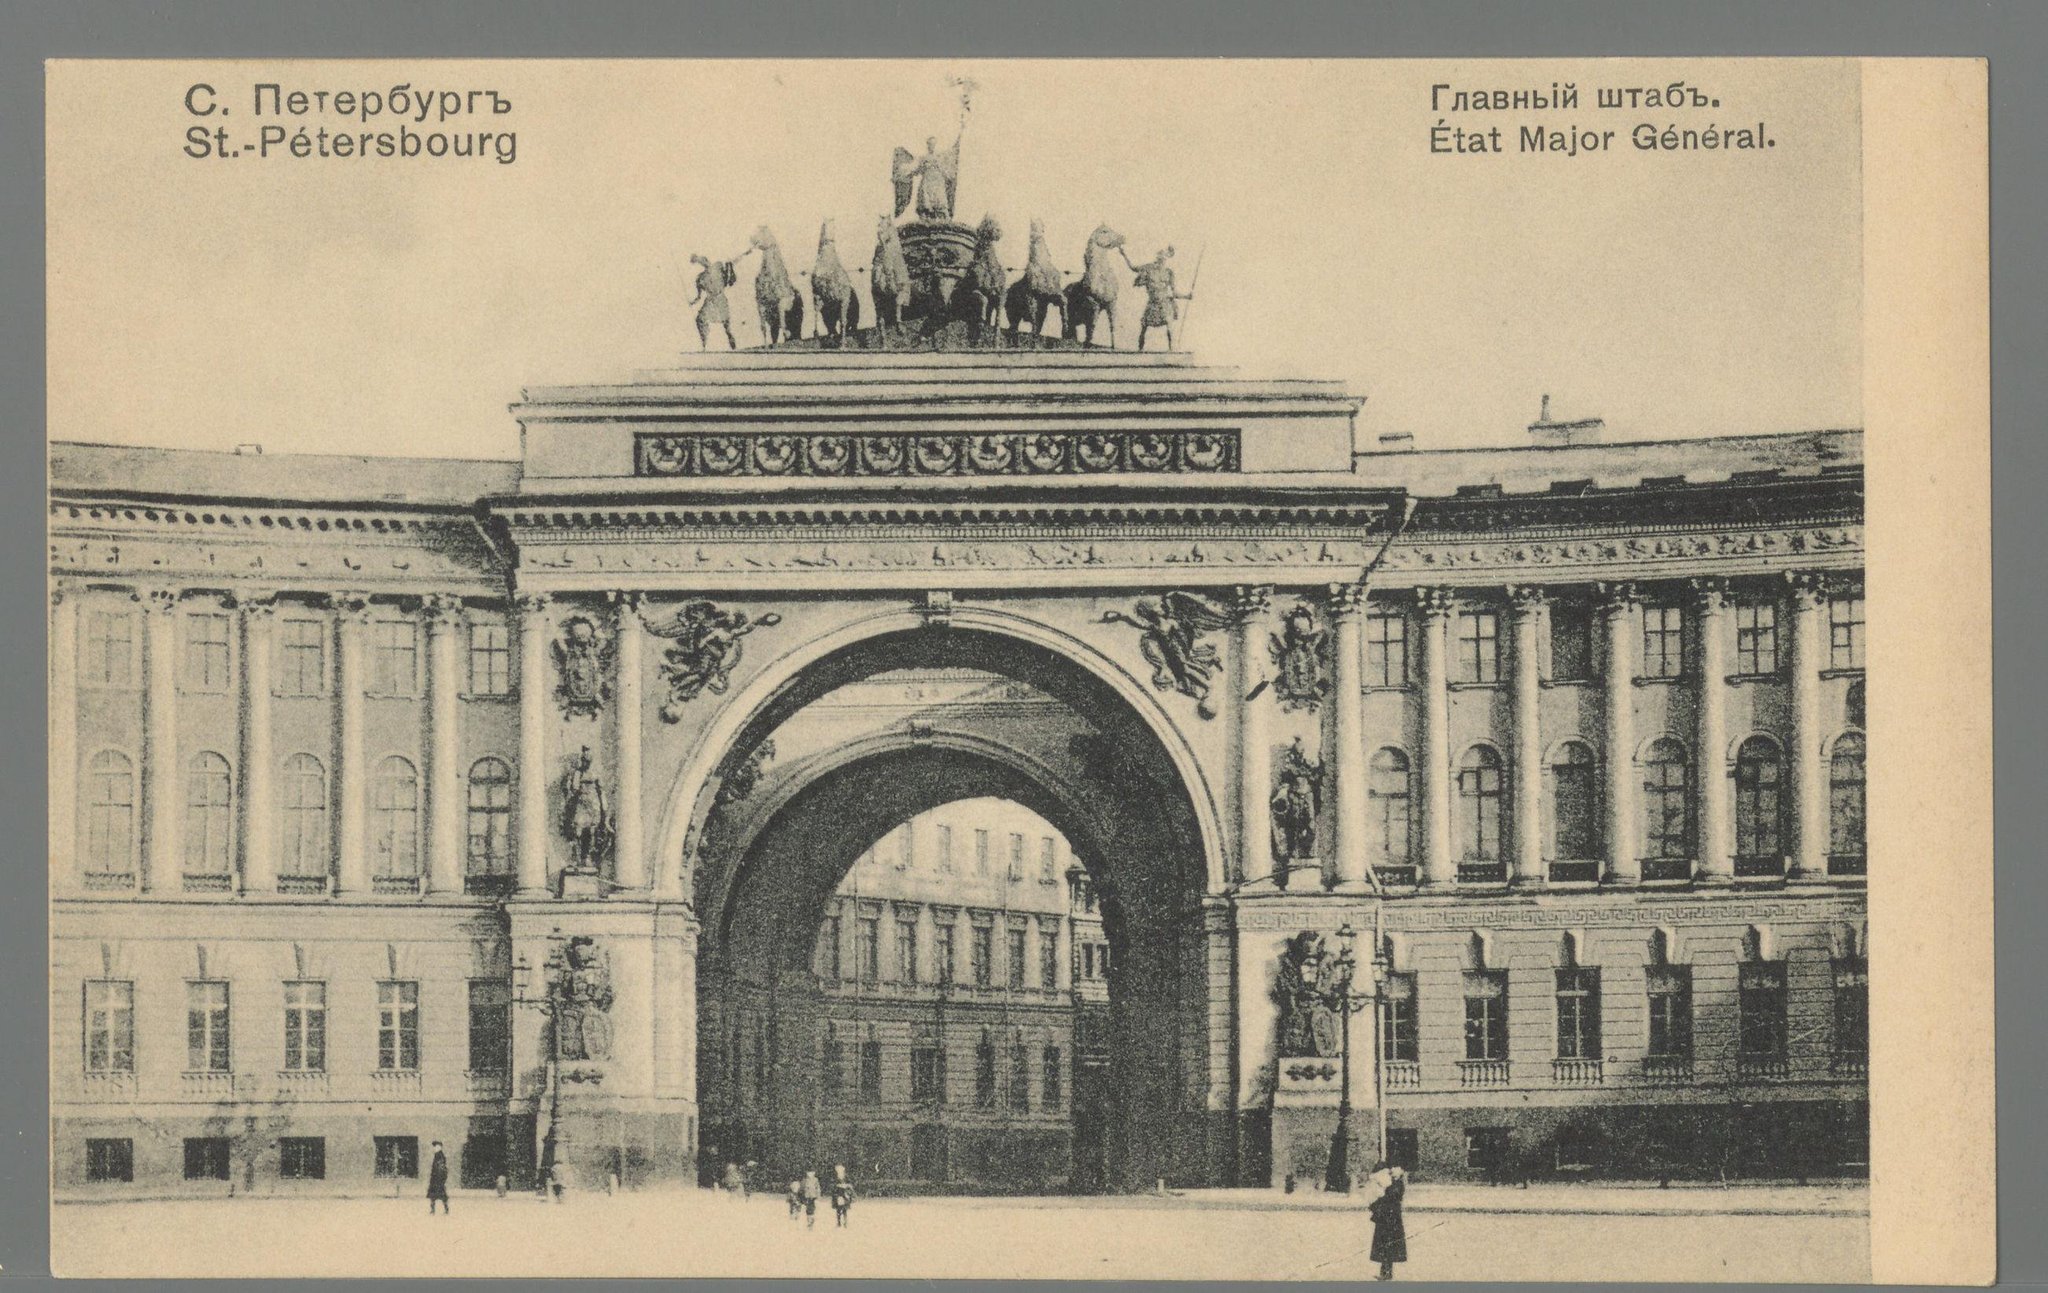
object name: photomechanical print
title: St.-Pétersbourg. État Major Général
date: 1904-1930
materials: cardboard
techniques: photograph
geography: sint-petersburg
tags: edifice, e.g.: public building, department store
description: Boven de Franse titel staat de titel in het Russisch.